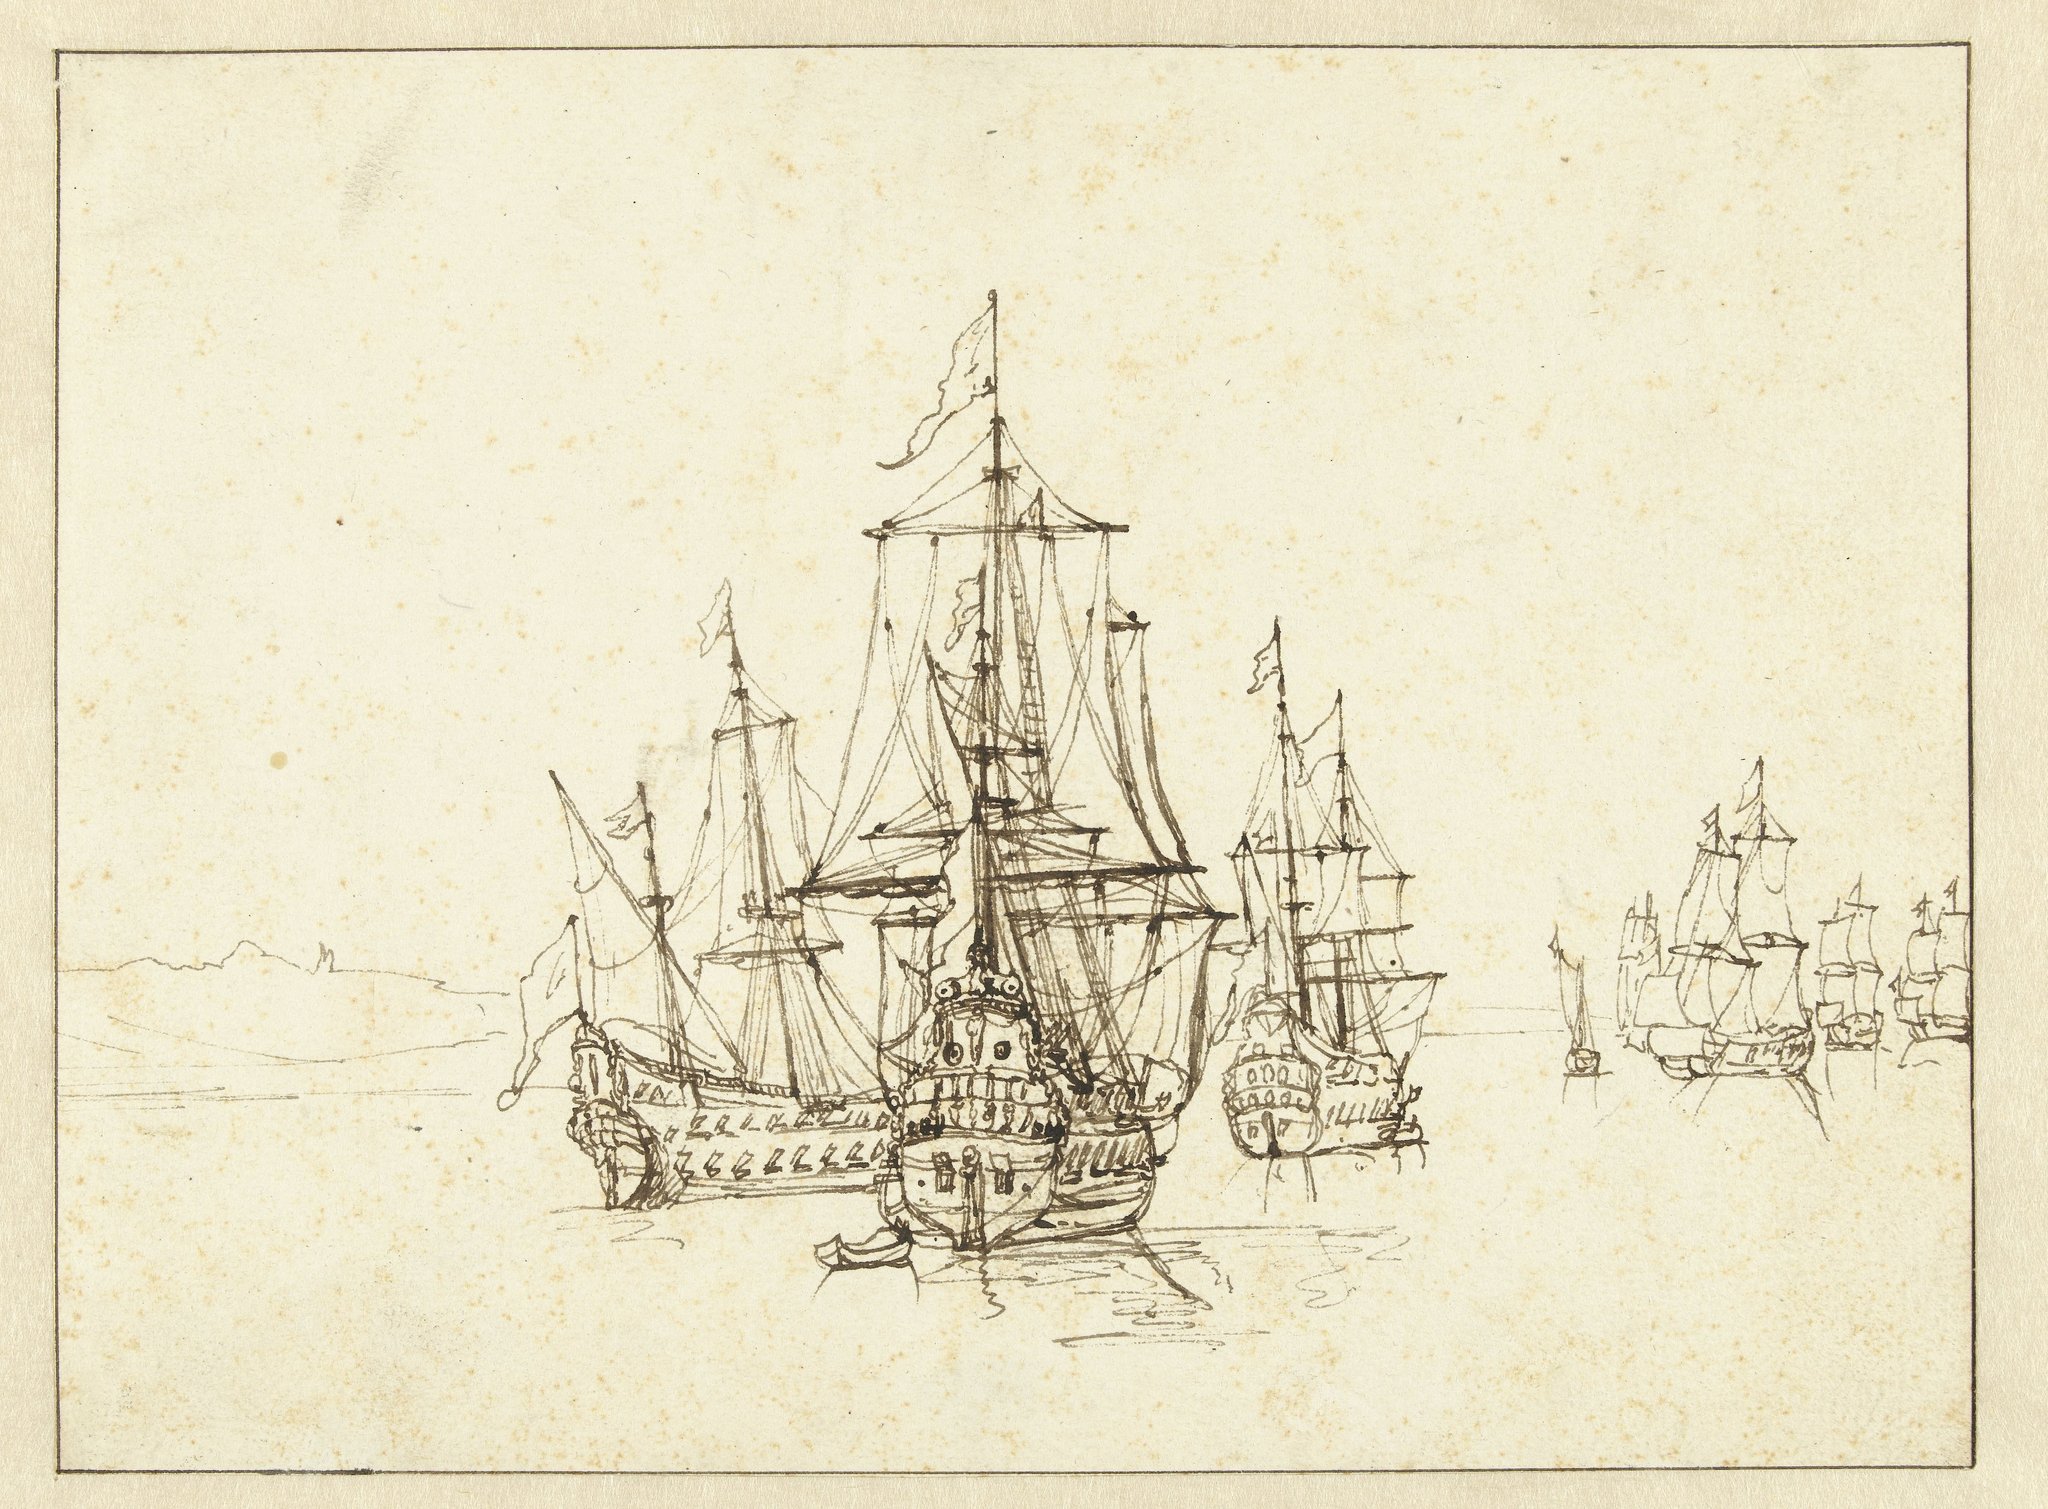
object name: drawing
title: Vloot oorlogsschepen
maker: Anonymous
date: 1600-1699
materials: ink, paper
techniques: pen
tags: sailing-ship, sailing-boat, navy (+ sailing-ships)